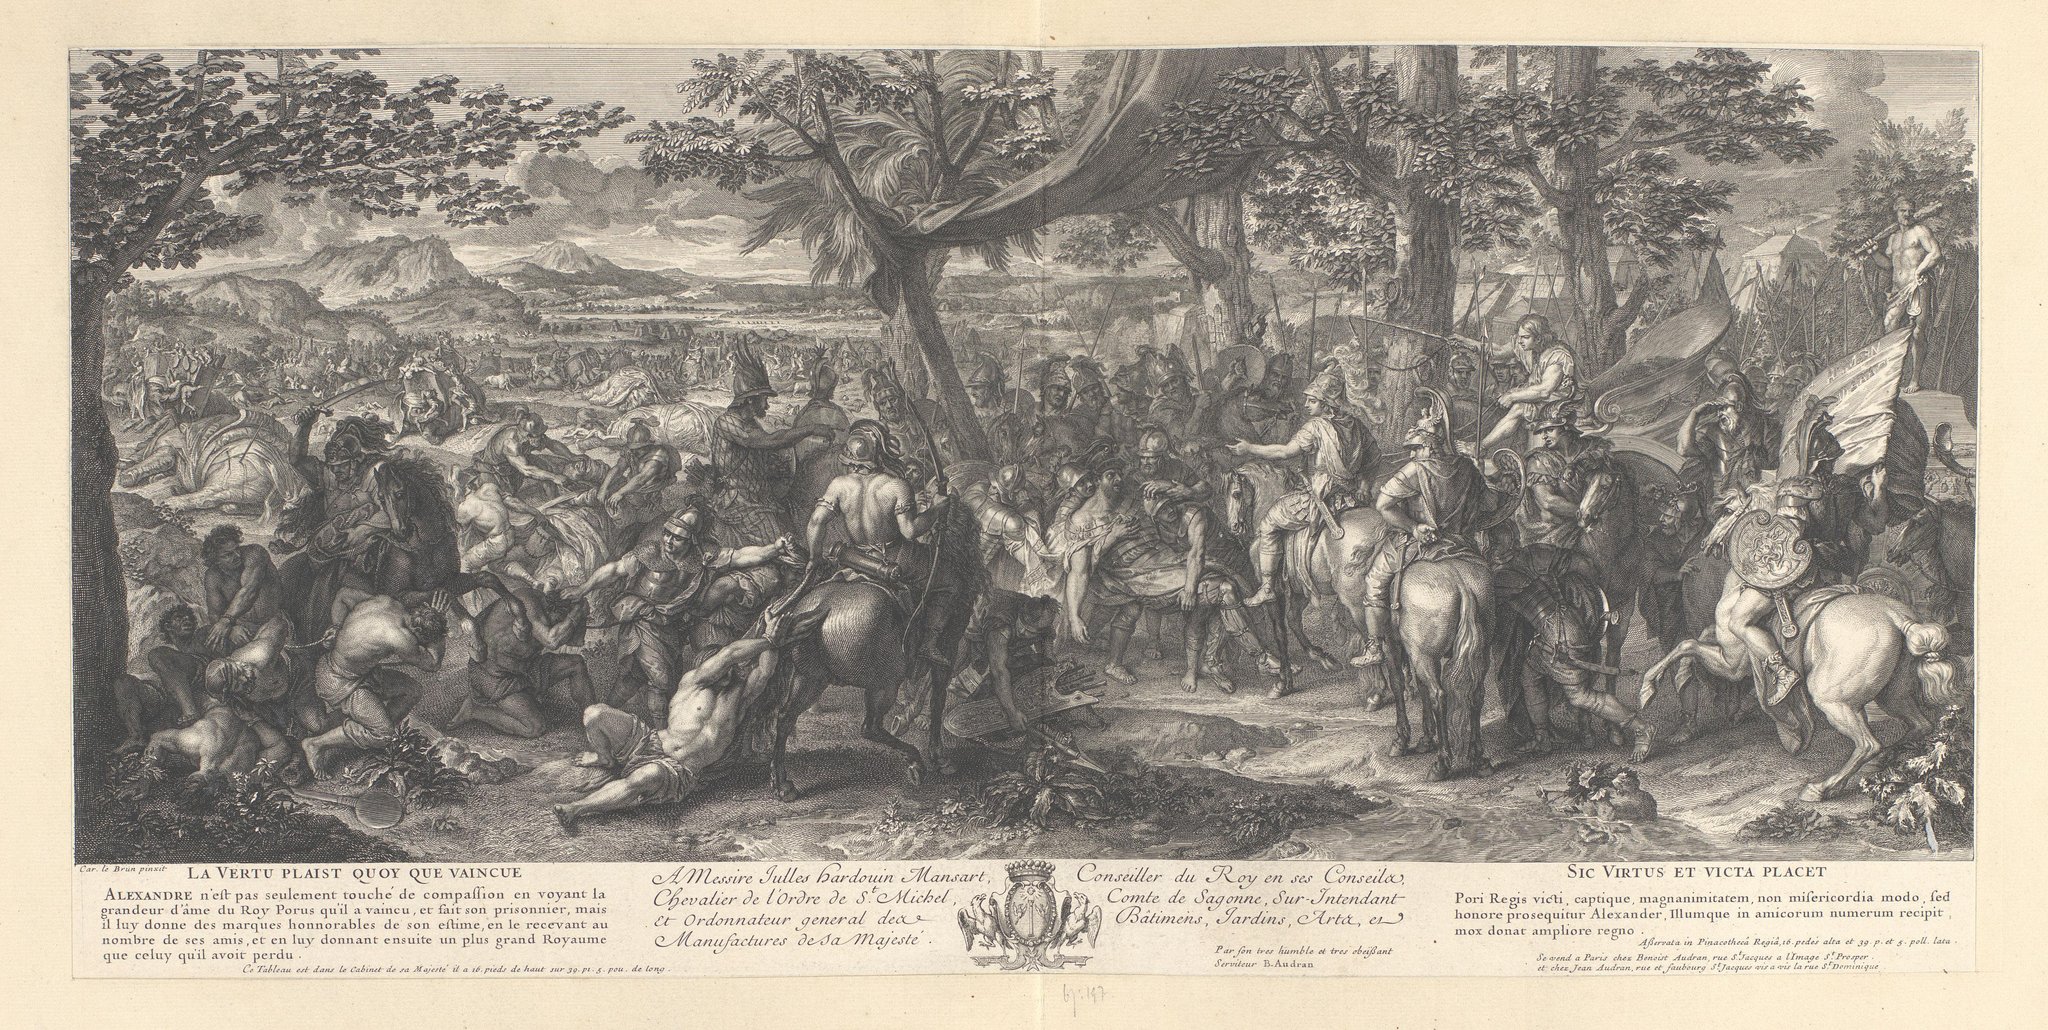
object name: print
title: Veldslagen van Alexander de Grote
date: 1671-1721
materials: paper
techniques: engraving, etching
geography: paris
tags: the defeated king porus, covered with wounds, comes before alexander, who restores his dominions, i.e. the clemency of alexander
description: Deze prent maakt deel uit van een album.